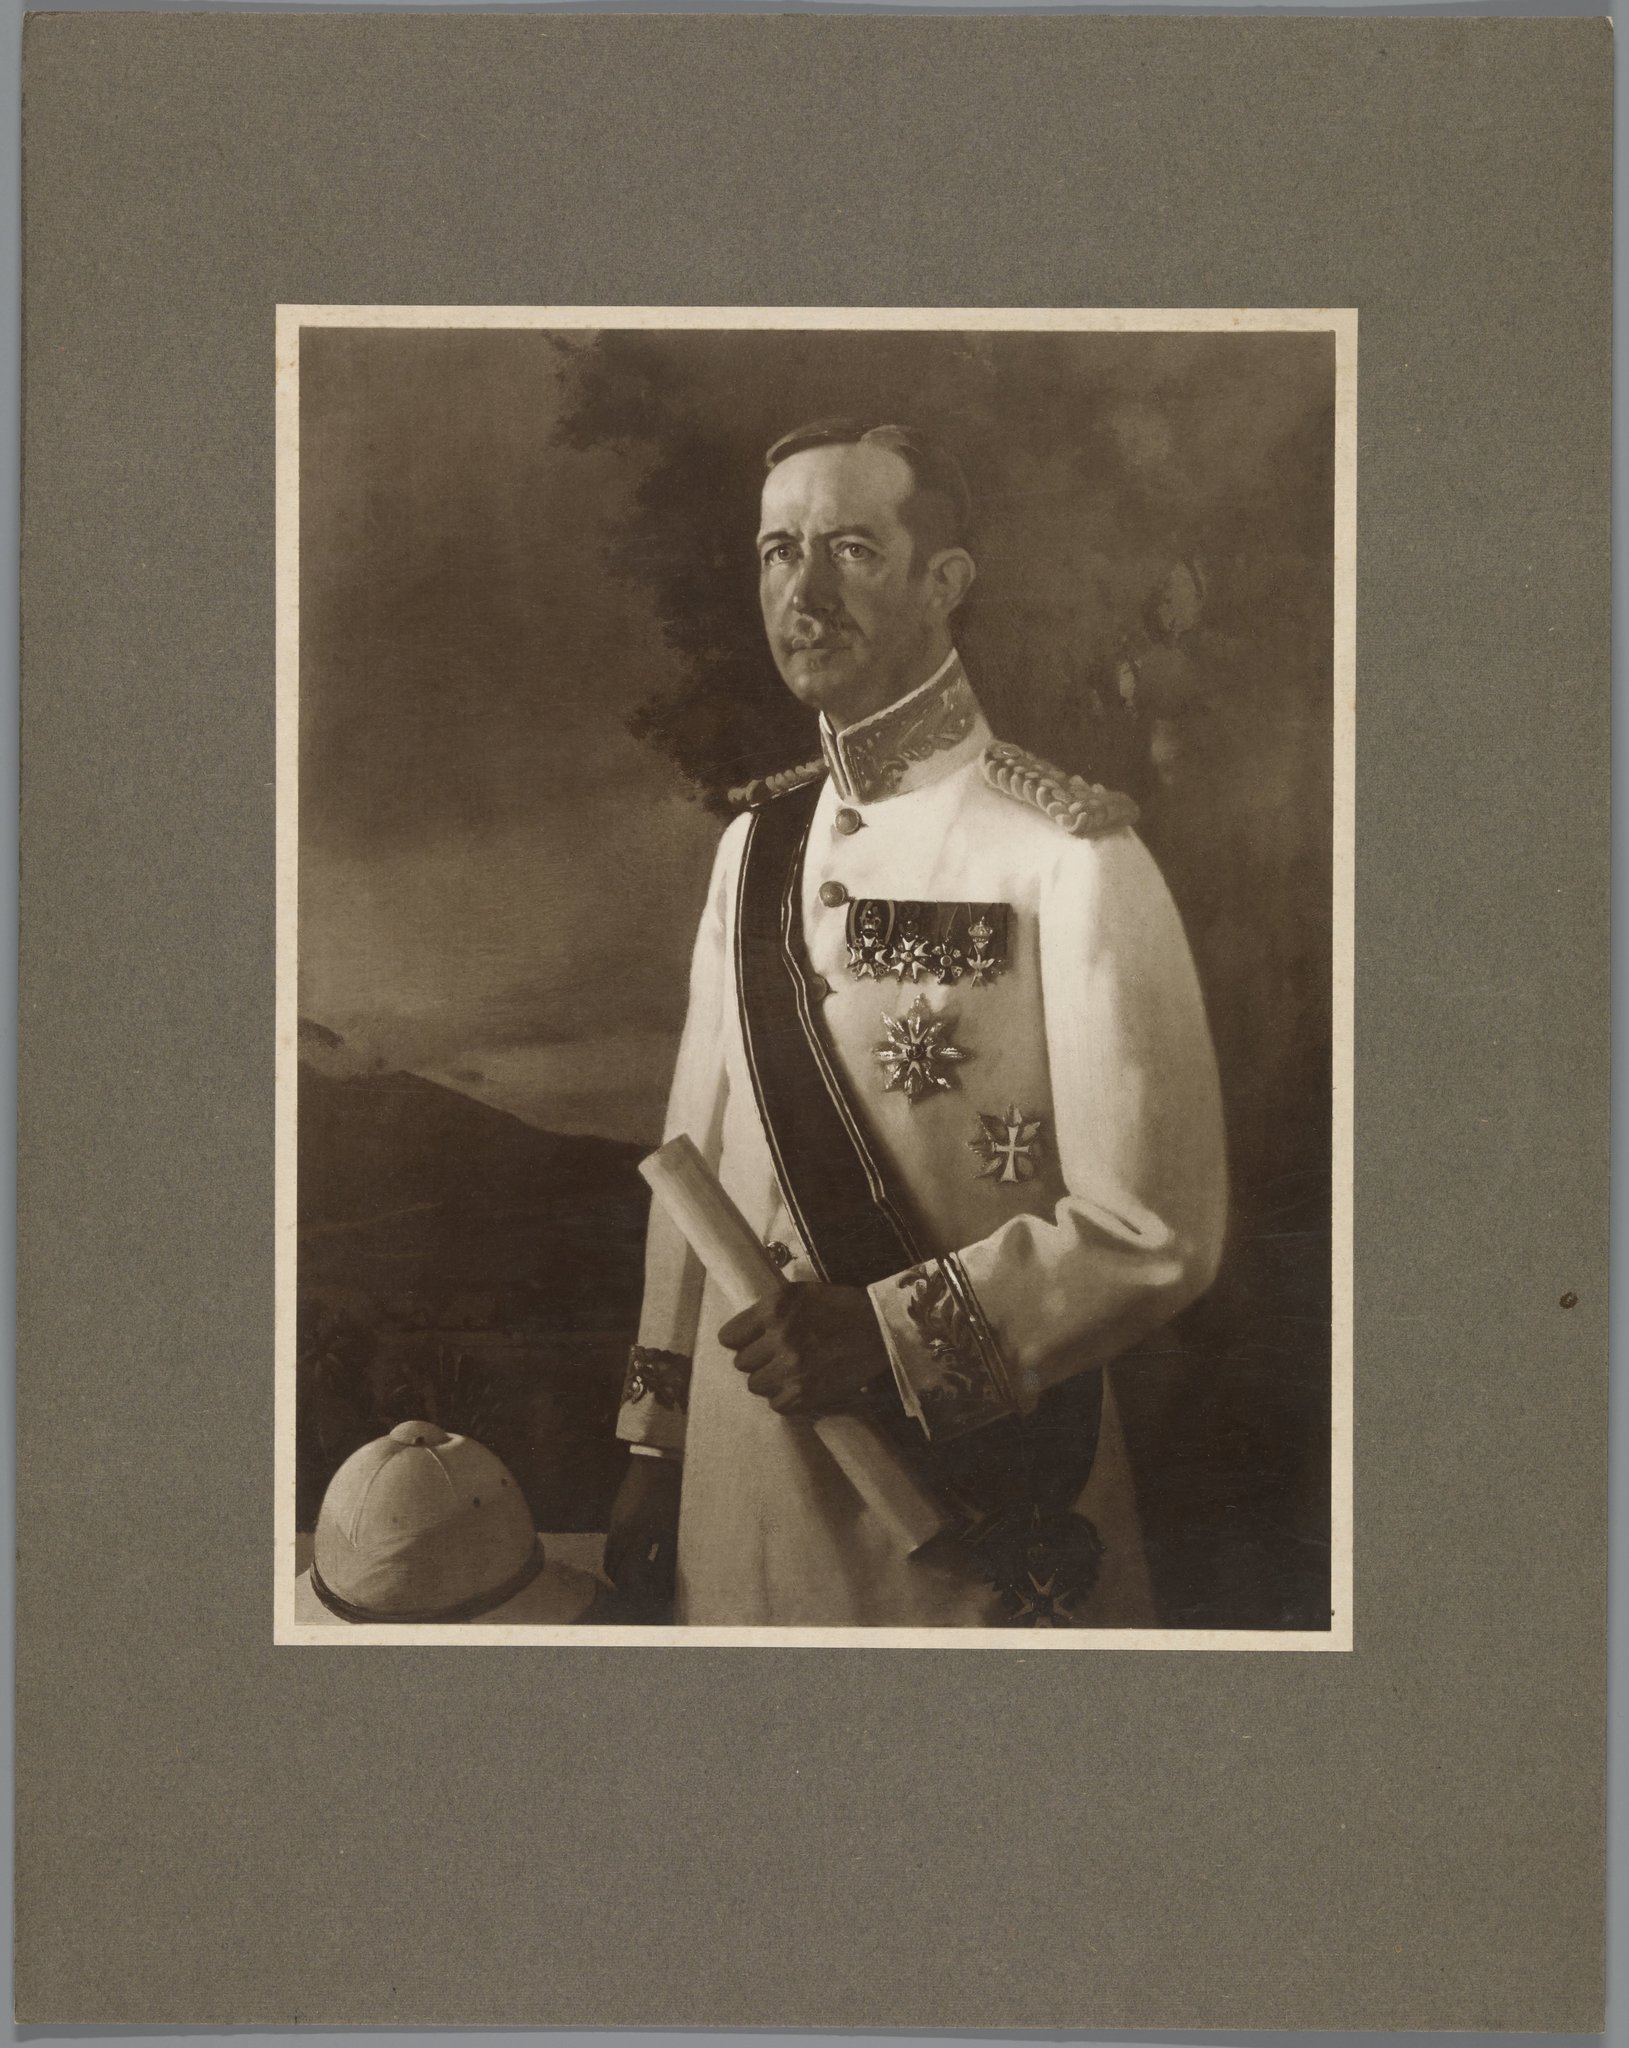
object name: photograph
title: Reproductie naar een verdwenen schilderij van Willem Witsen van een portret van J.P. van Limburg-Stirum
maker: Anonymous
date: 1860-1915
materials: cardboard, paper, photographic support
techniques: gelatin silver print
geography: netherlands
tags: zwolle, johan paul graaf van limburg stirum